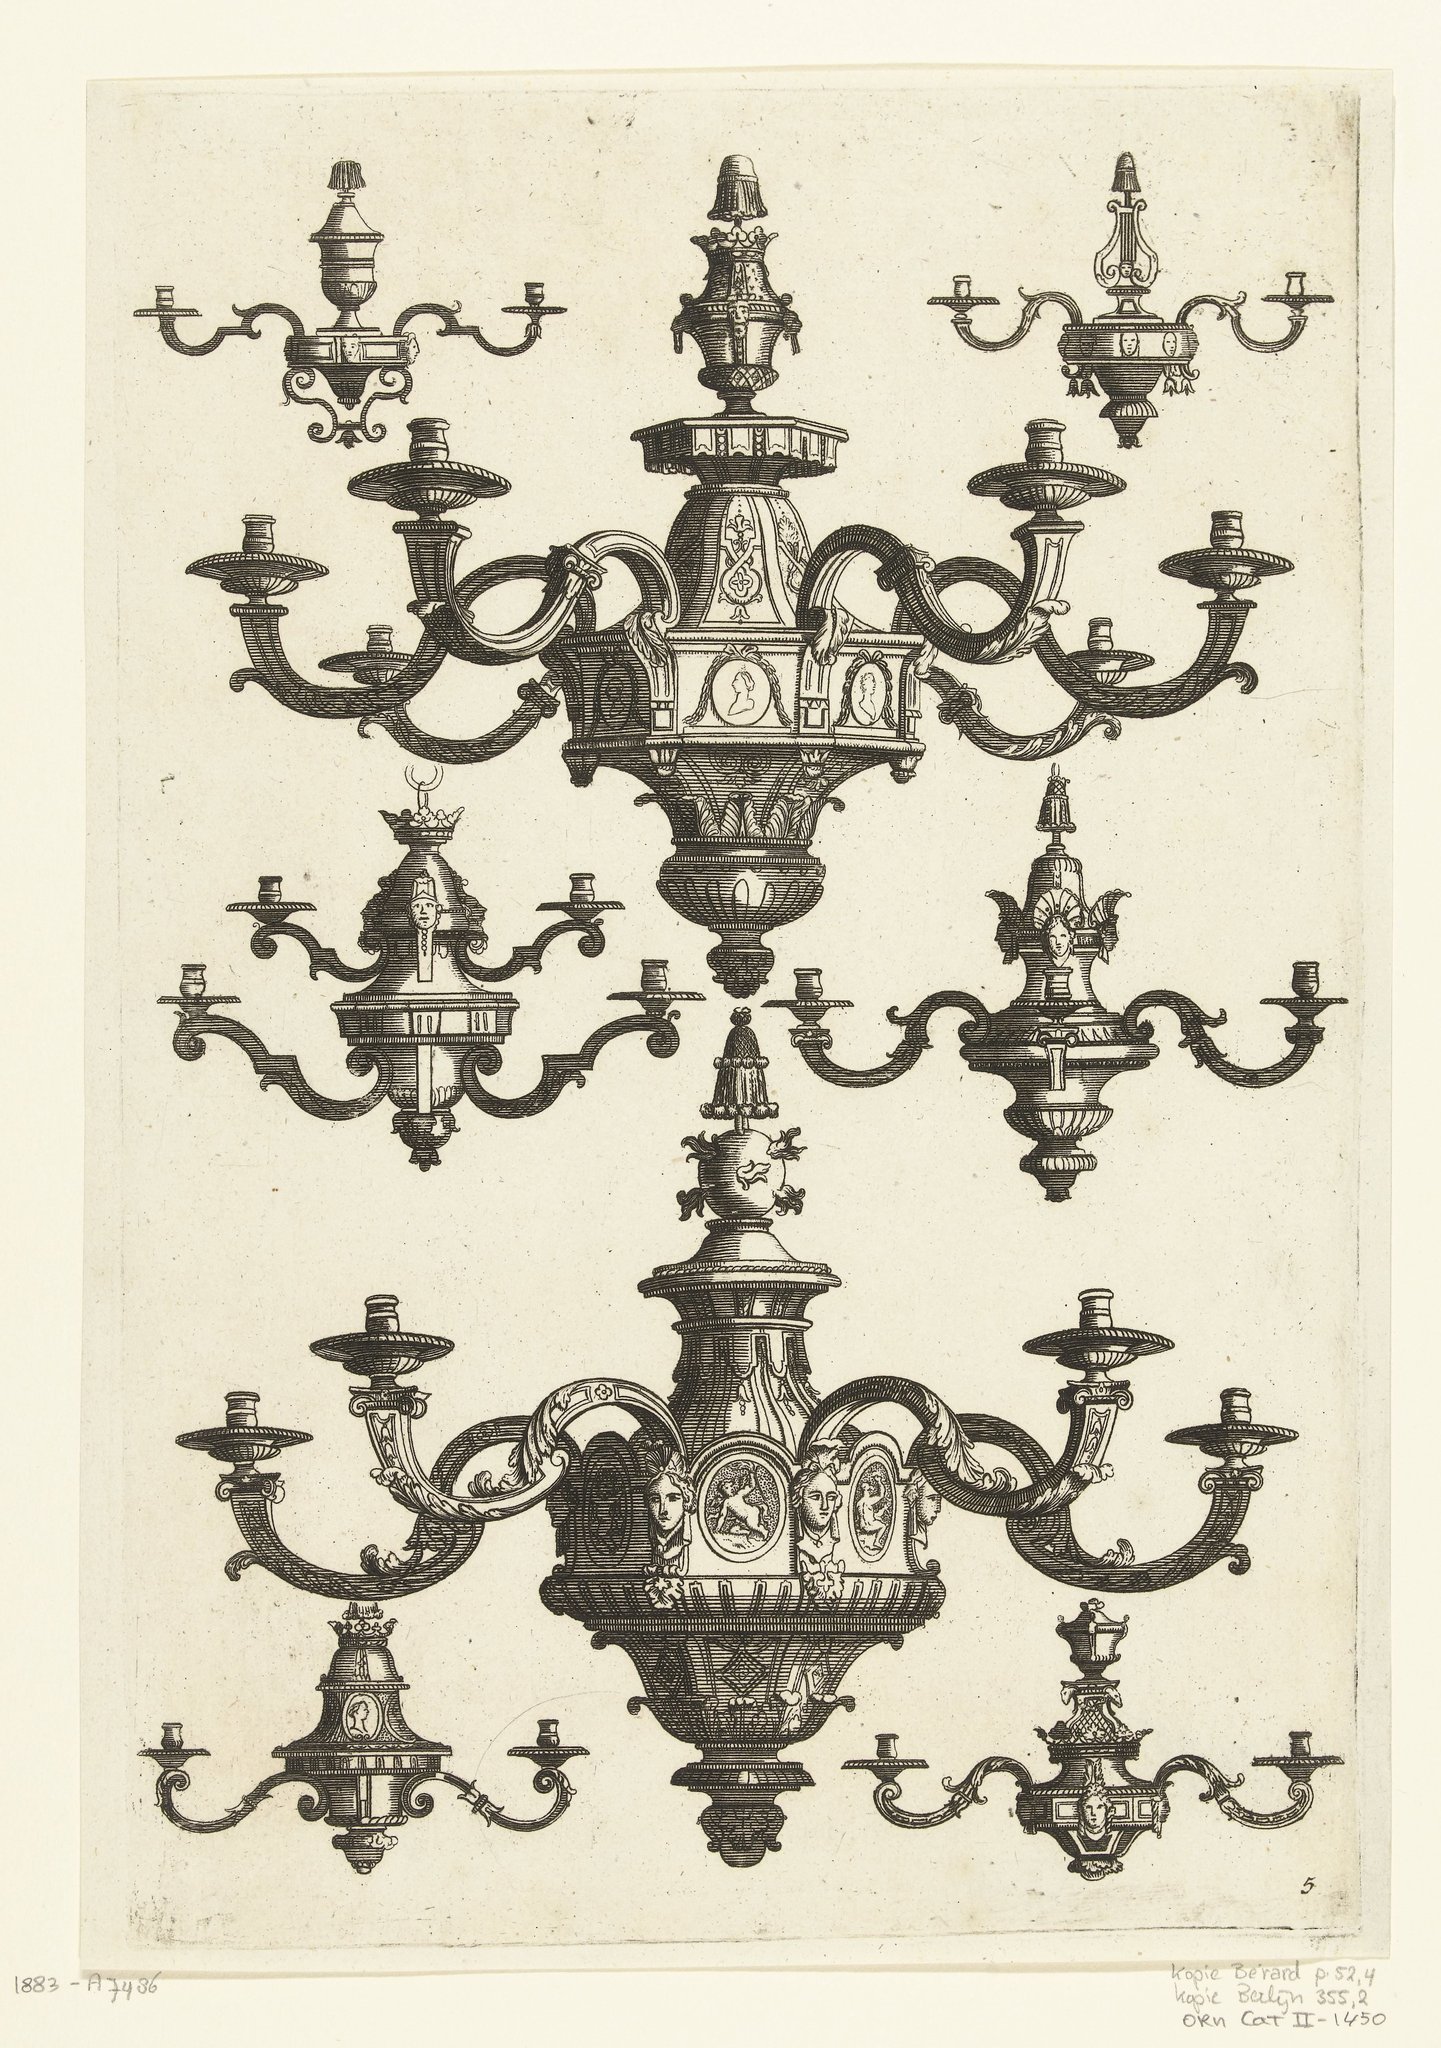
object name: ornament print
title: Nouveaux Liure d'Orfeureire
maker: Anonymous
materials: paper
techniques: etching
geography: netherlands